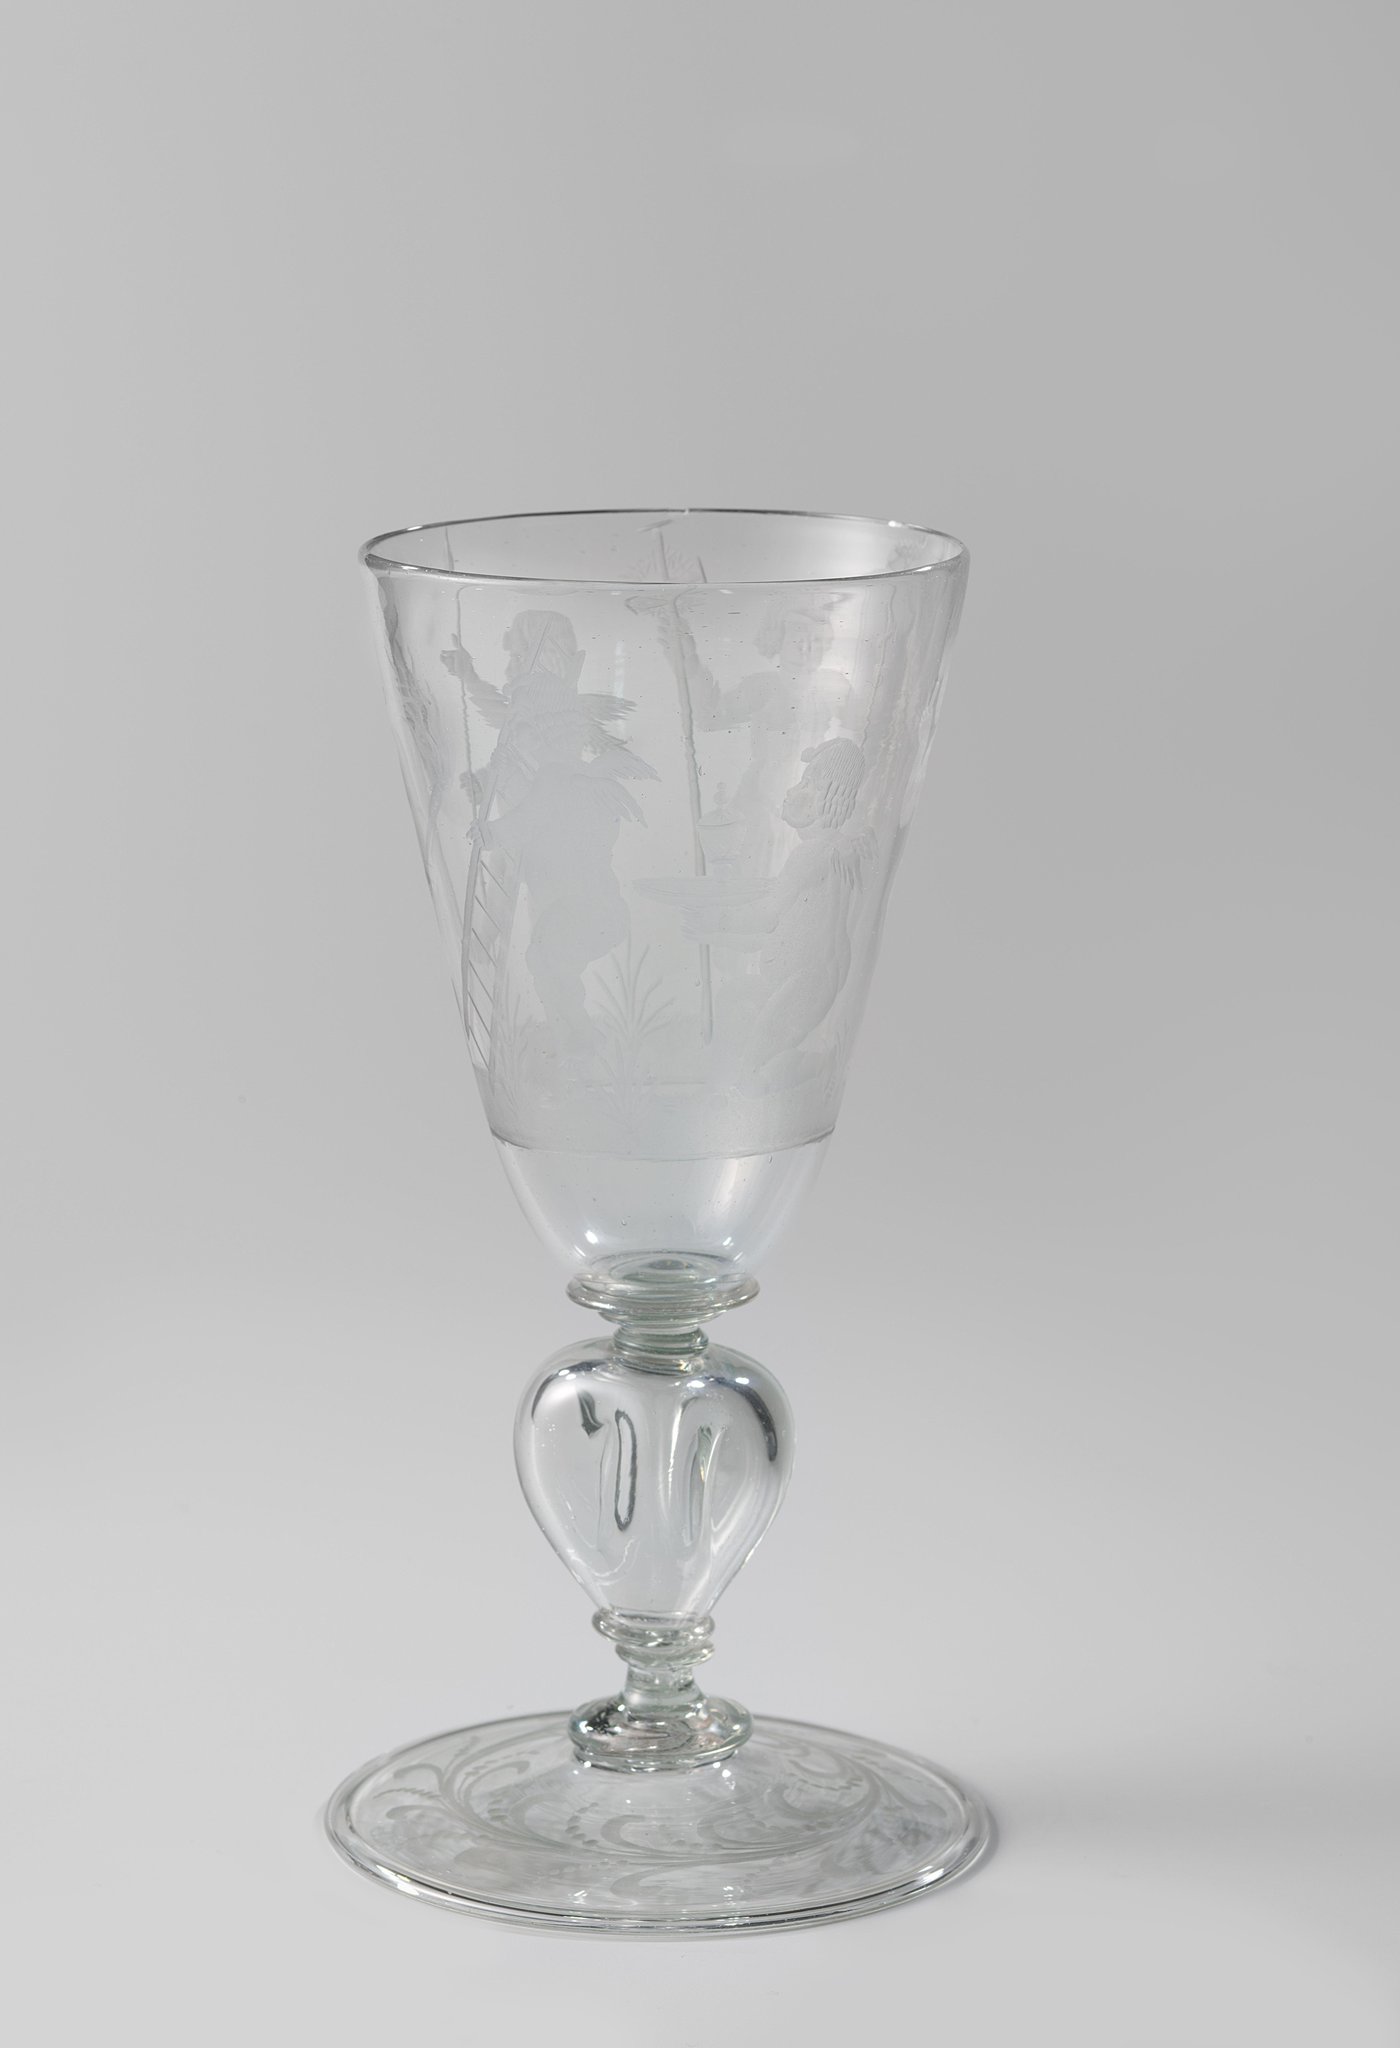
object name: goblet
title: Bokaal met zes putti met schoorsteenvegersgereedschap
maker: Anonymous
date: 1680-1700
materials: glass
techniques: façon de venise, glassblowing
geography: northern netherlands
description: Wine glass. Wheel engraving with putti with chimney sweeping tools. Northern Netherlands, c. 1680 - 1700. A.J. Enschedé bequest, 1896.